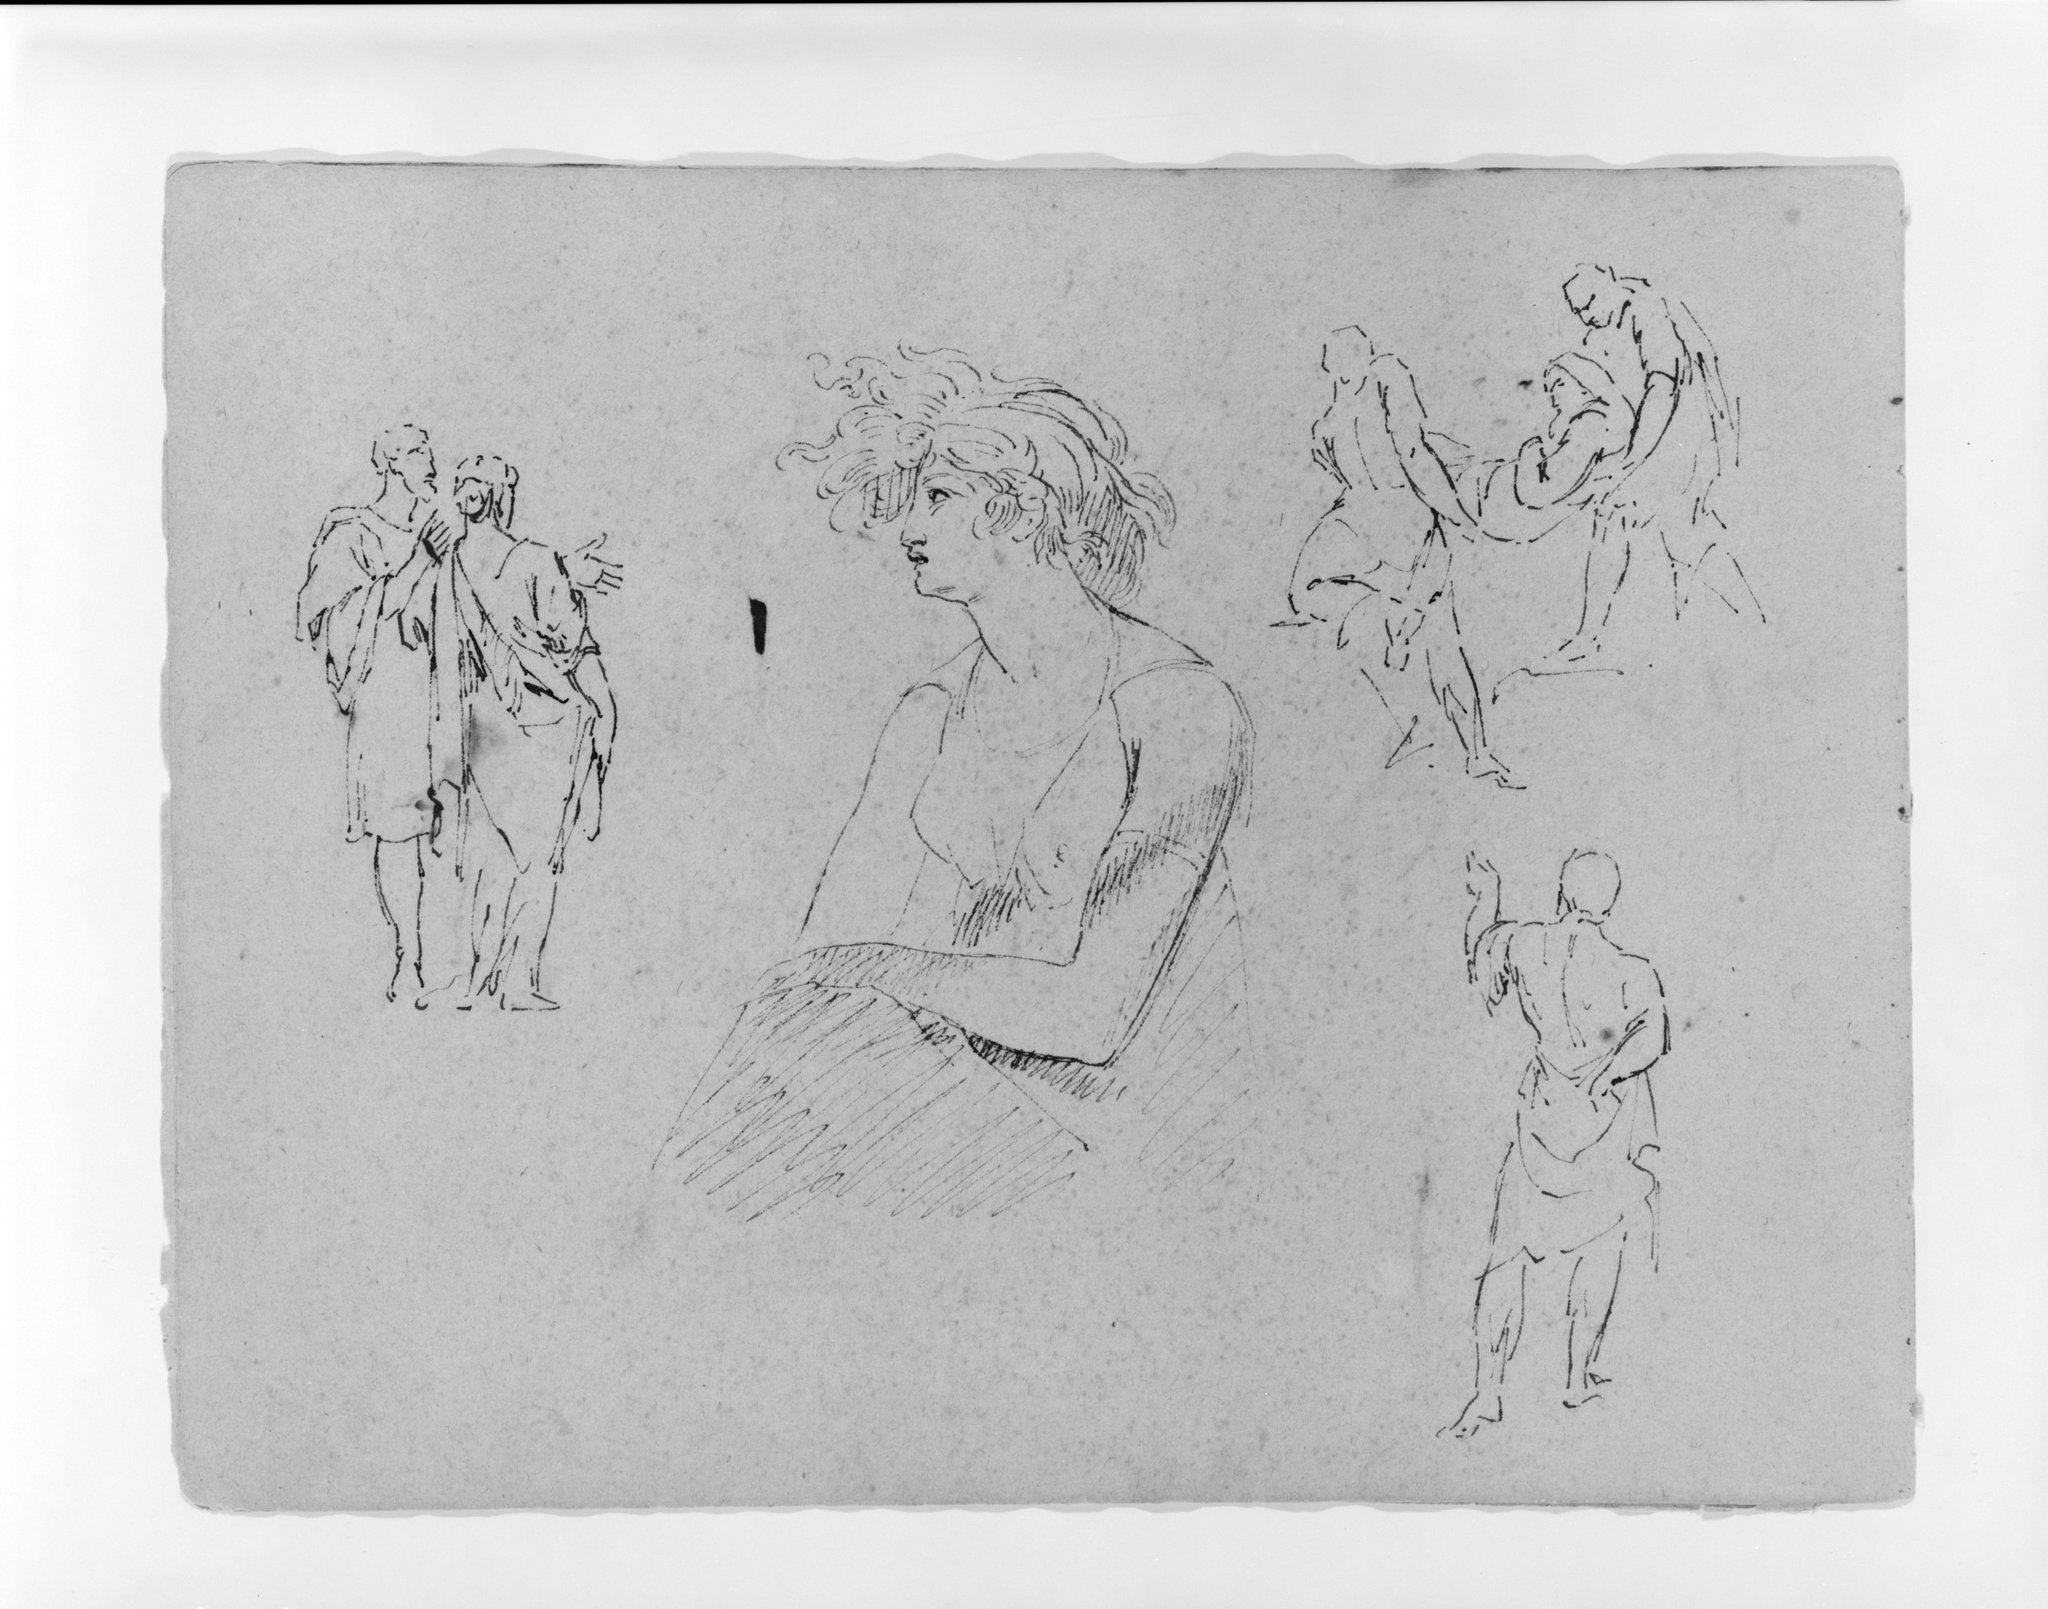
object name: drawing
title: (From Sketchbook)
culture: american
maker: thomas sully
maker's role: artist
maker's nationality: american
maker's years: 1783-1872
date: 1810-1820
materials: ink, paper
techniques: wash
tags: men,women